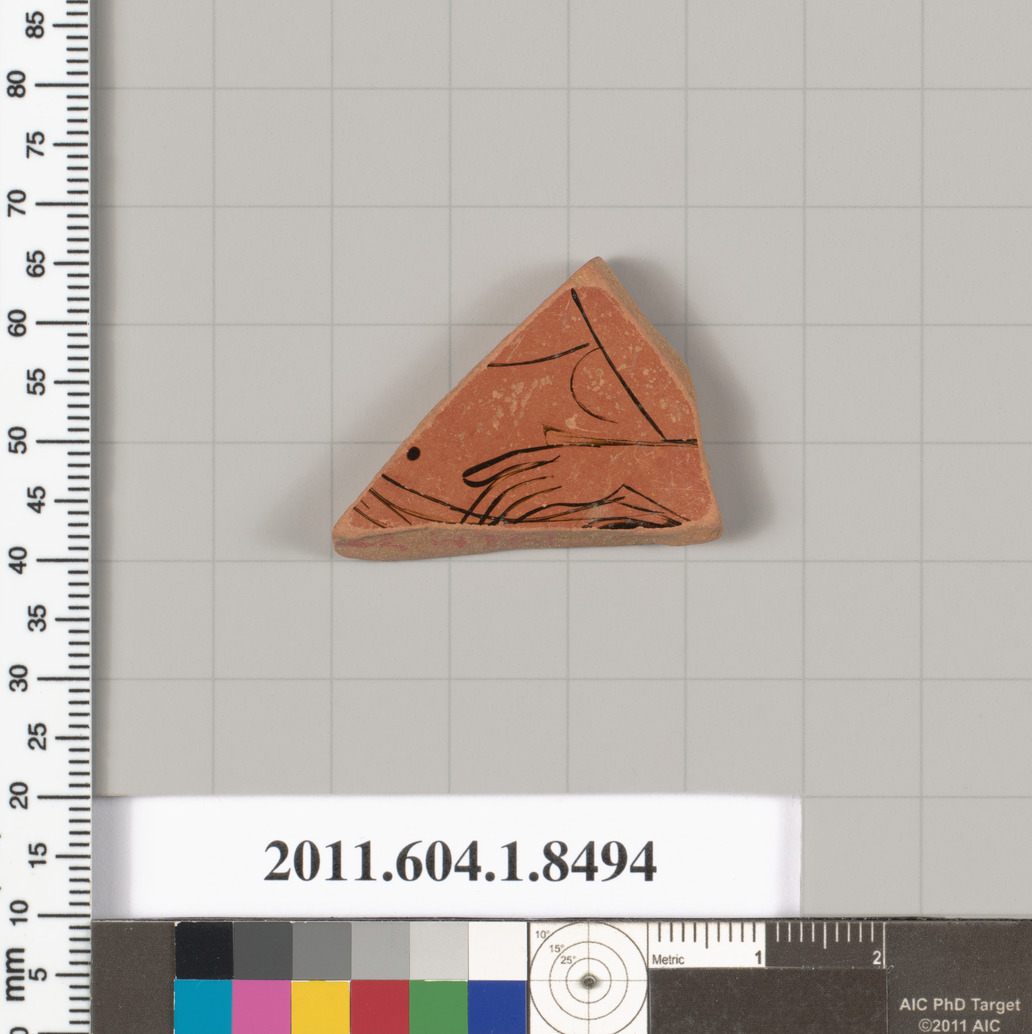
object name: kylix fragment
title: Terracotta fragment of a stemless kylix (drinking cup)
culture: greek, attic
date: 475-451 BCE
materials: terracotta